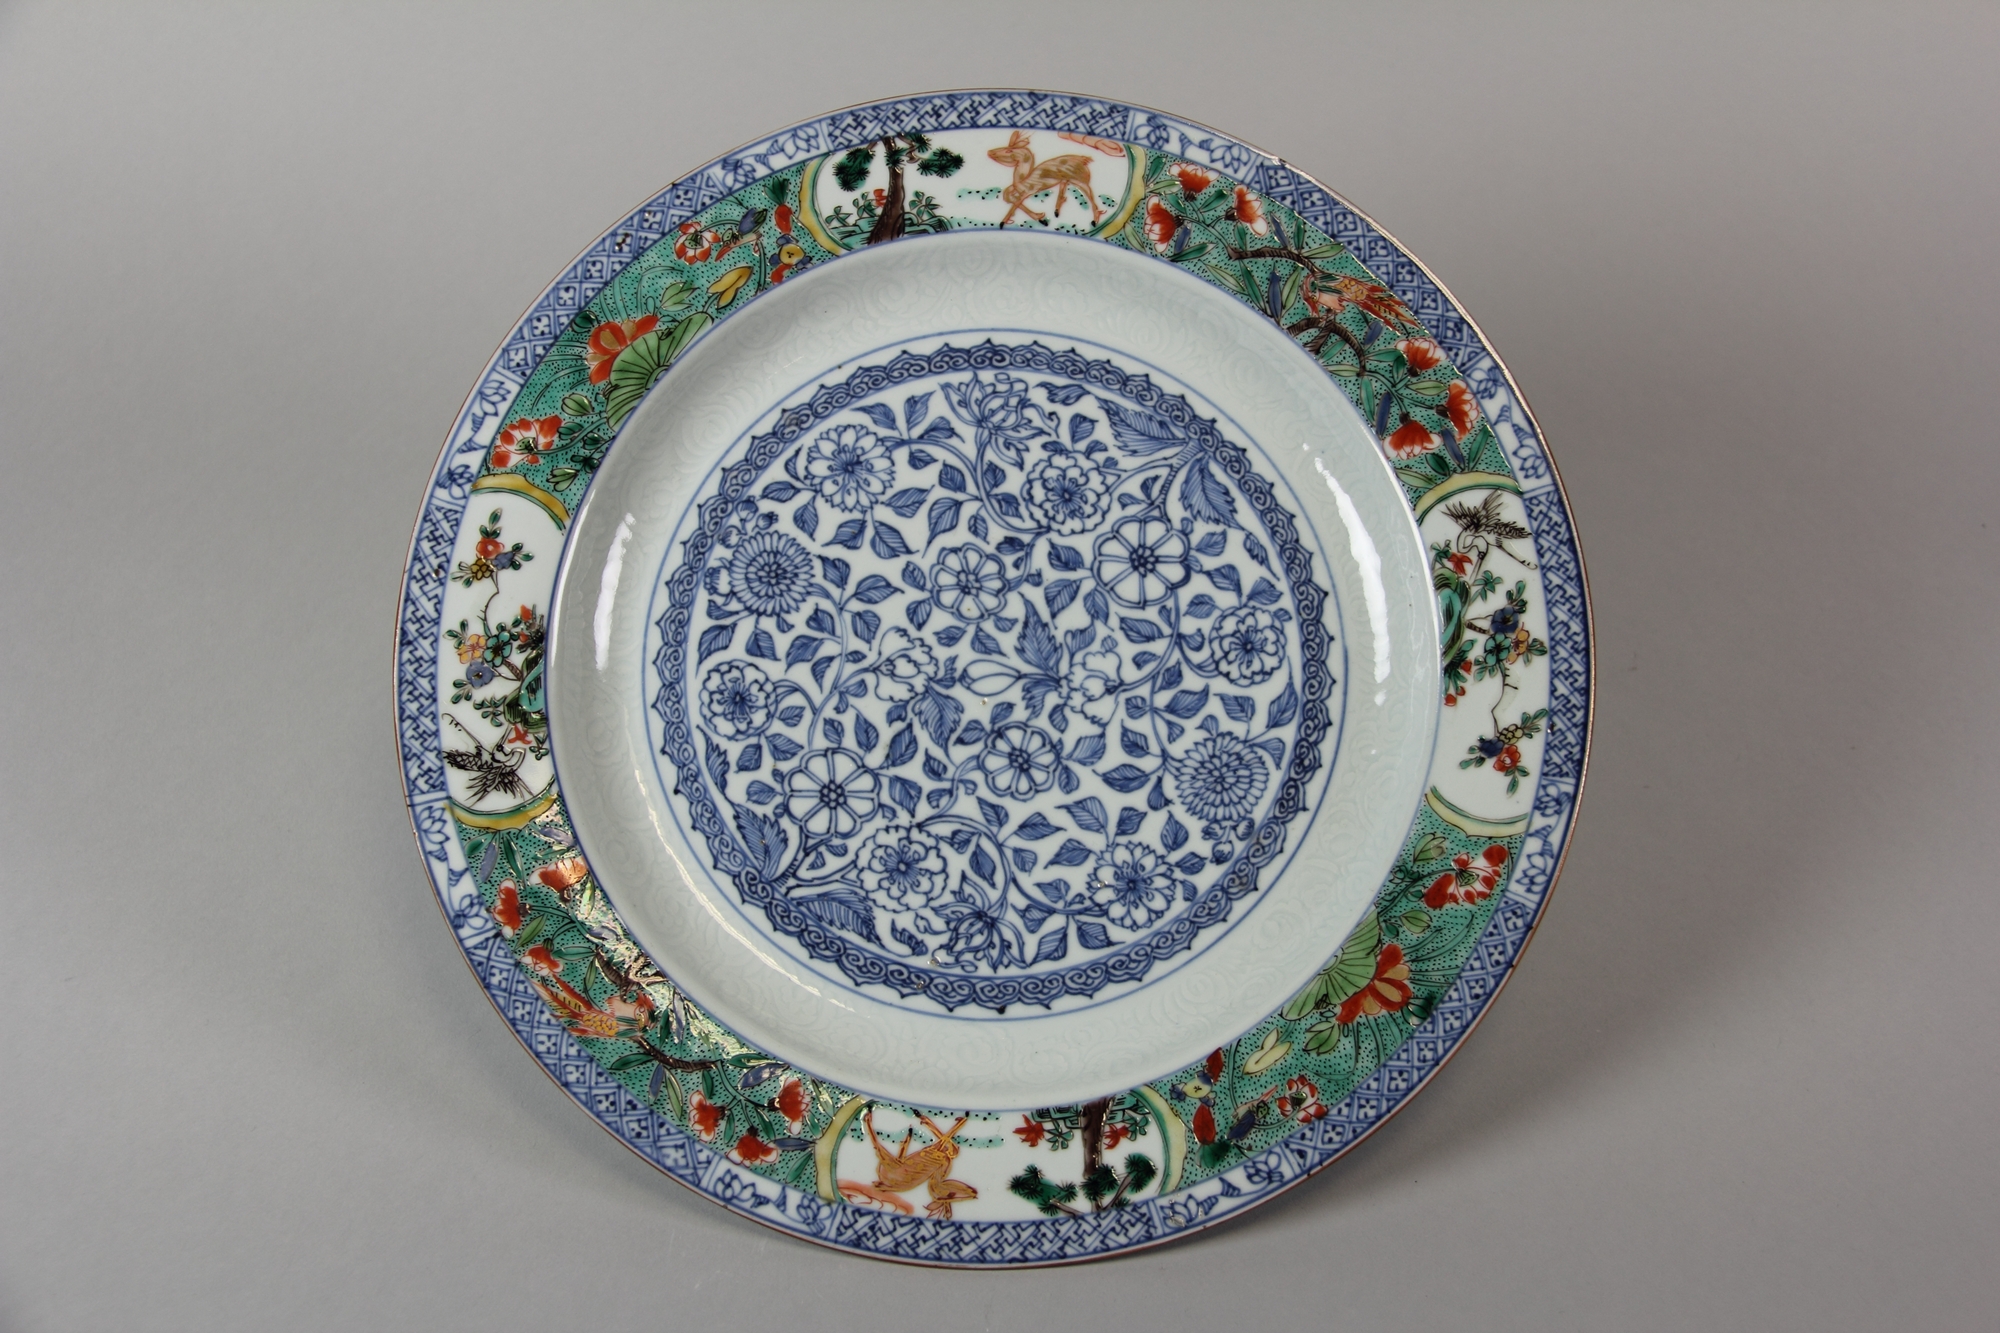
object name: plate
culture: chinese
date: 1644-1911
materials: enamel, porcelain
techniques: incising, overglaze, painting, polychrome, underglaze